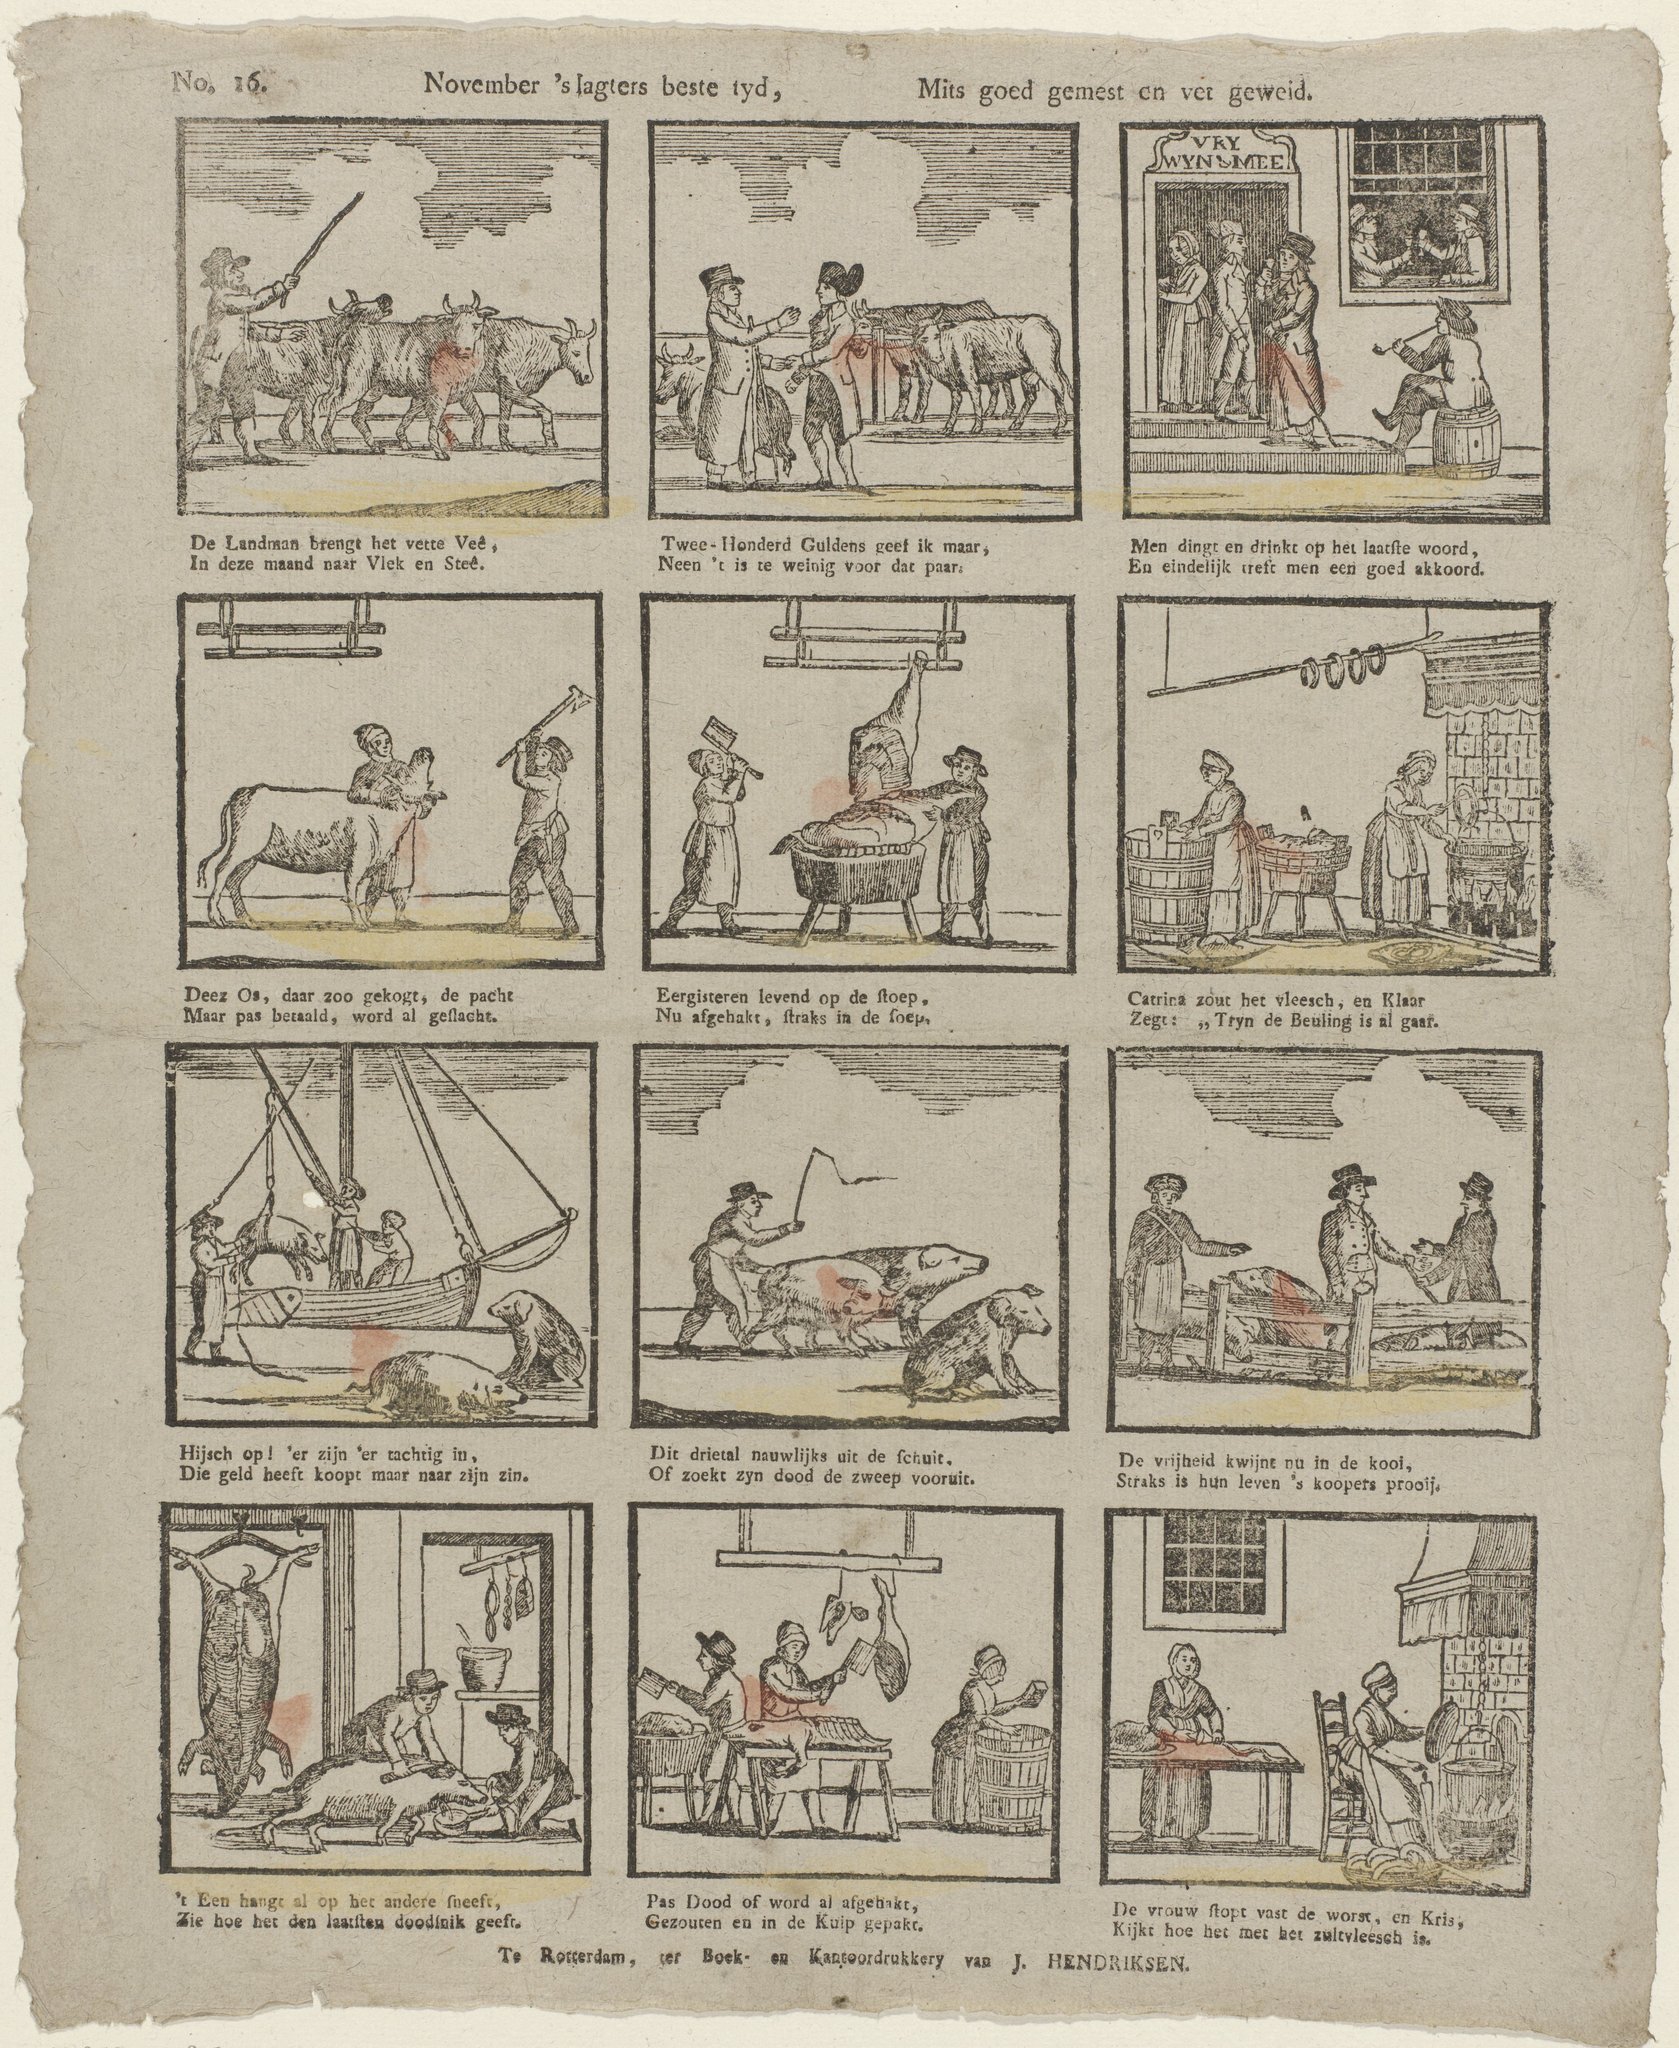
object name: print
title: November 'slagters beste tyd, / Mits goed gemest en vet geweid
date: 1781-1828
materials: paper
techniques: colour, letterpress printing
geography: rotterdam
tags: slaughtered ox or pig, butcher, slaughterman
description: Blad met 12 voorstellingen van het fokken, slachten en bereiden van koeien en varkens. Onder elke afbeelding een tweeregelig vers. Genummerd linksboven: No. 16.